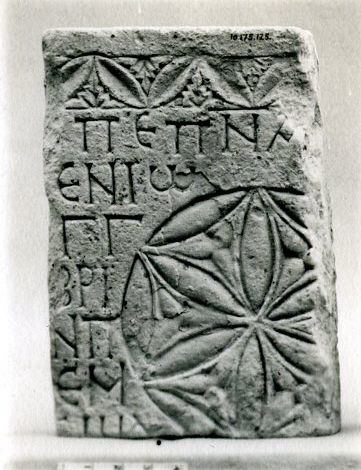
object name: fragment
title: Fragment of an Inscribed Slab with a Rosette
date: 501-700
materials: limestone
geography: egypt